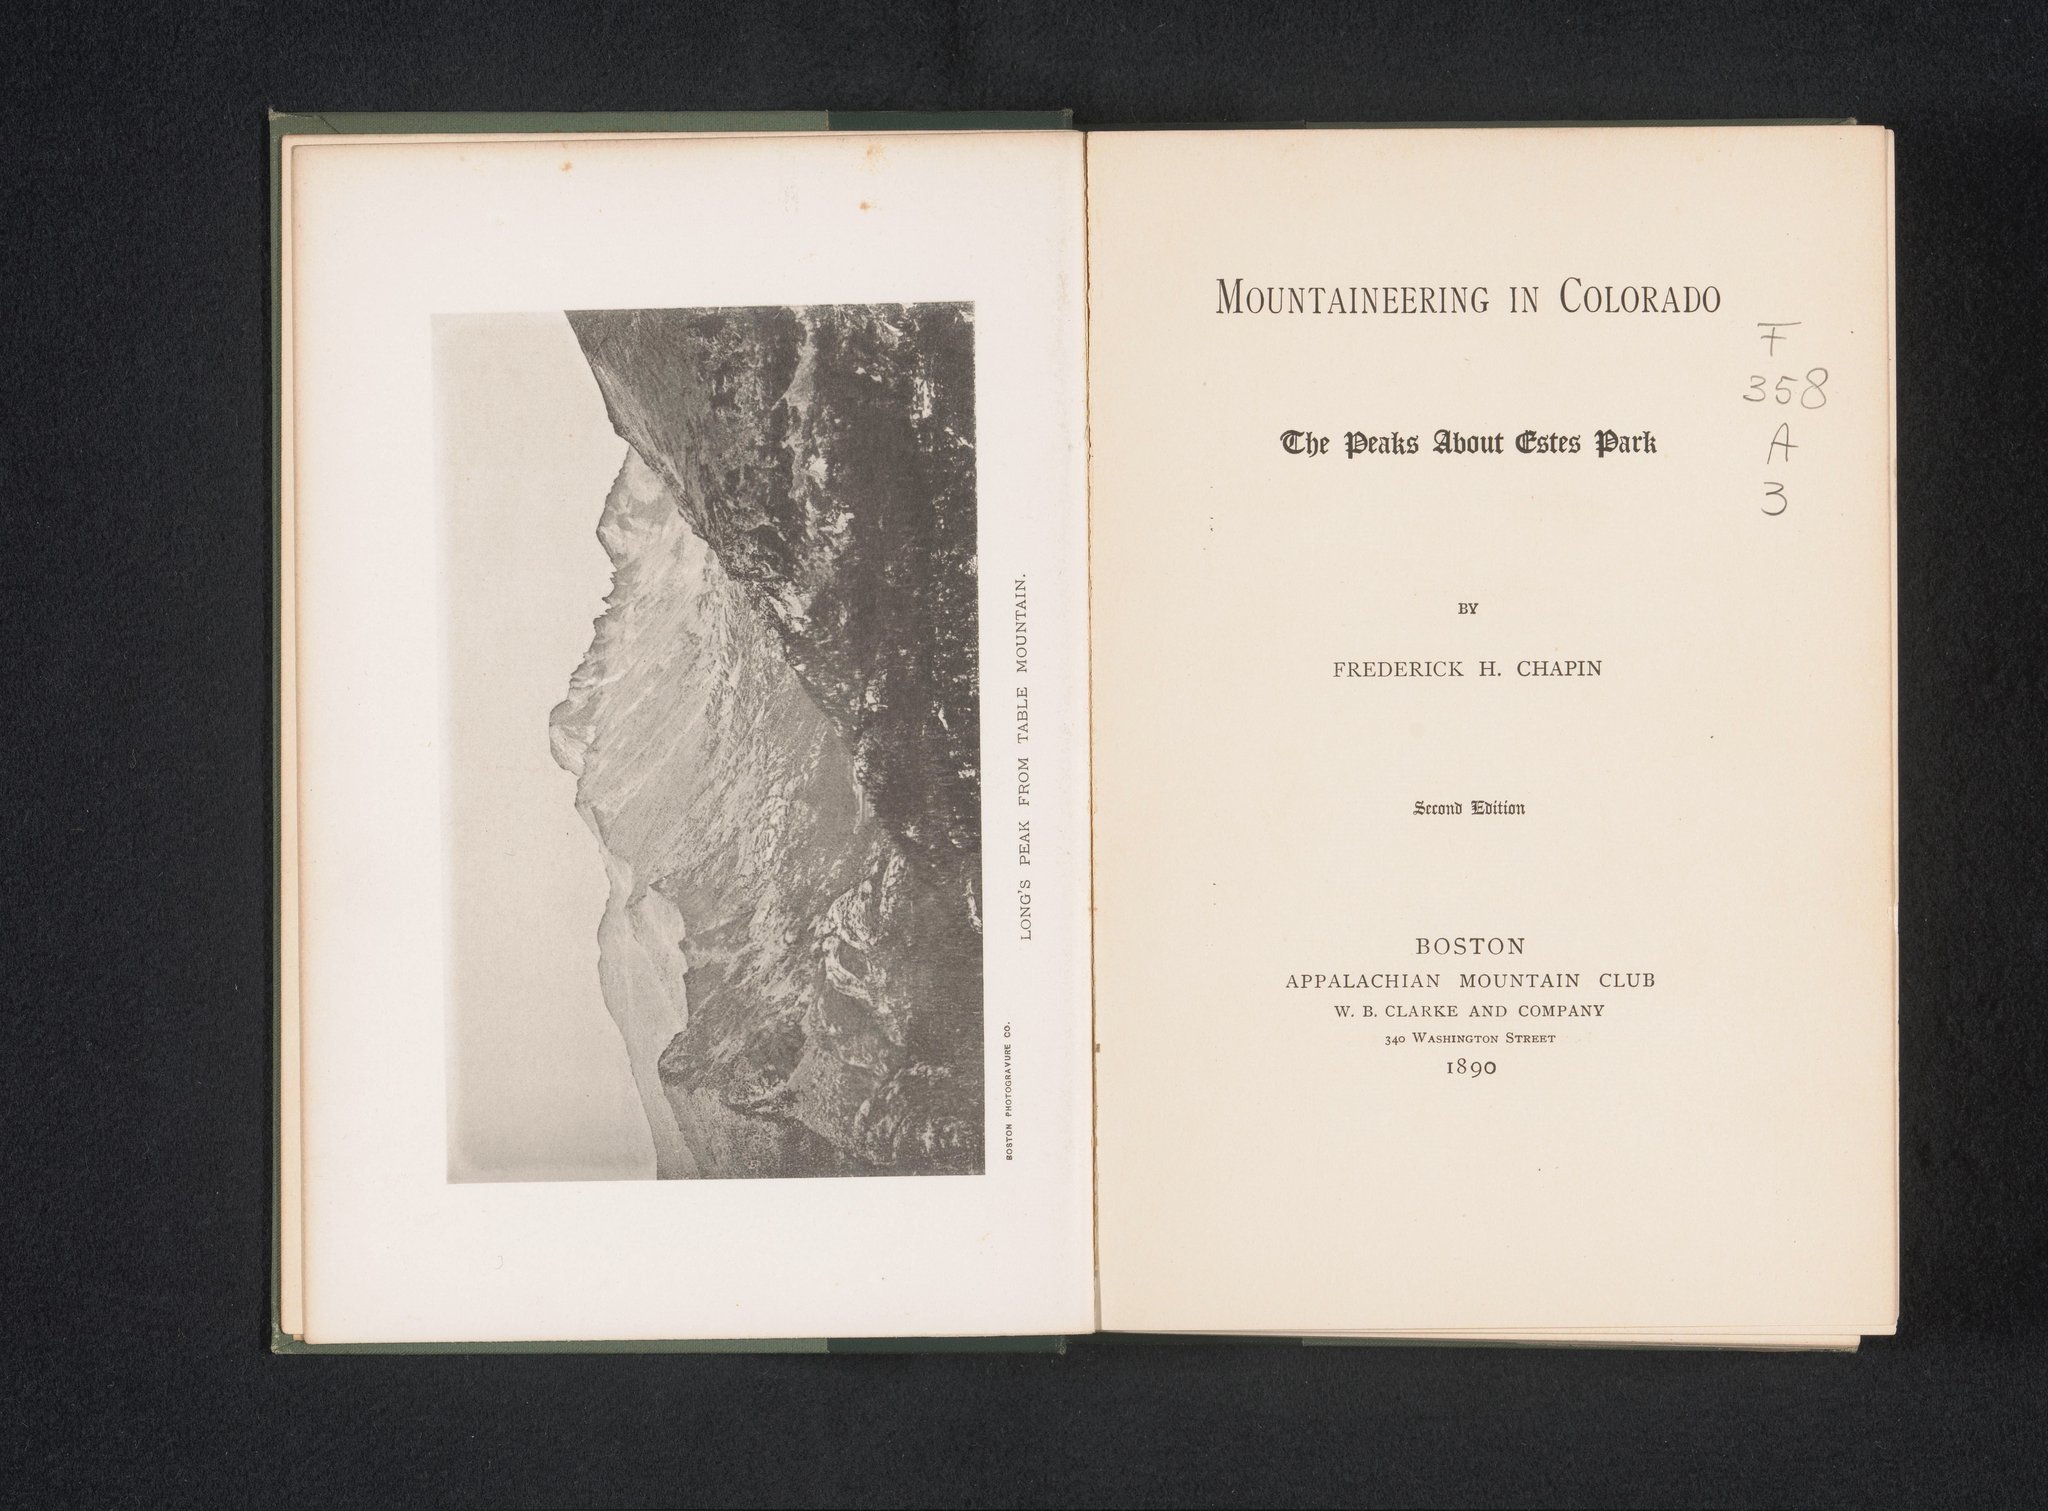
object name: photomechanical print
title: Gezicht op Longs Peak in het Rocky Mountain National Park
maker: frederick hastings chapin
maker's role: antropoloog, archeoloog, fotograaf, schrijver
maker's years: 1852-1900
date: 1885-1890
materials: paper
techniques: photograph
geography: boston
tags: landscapes, mountains